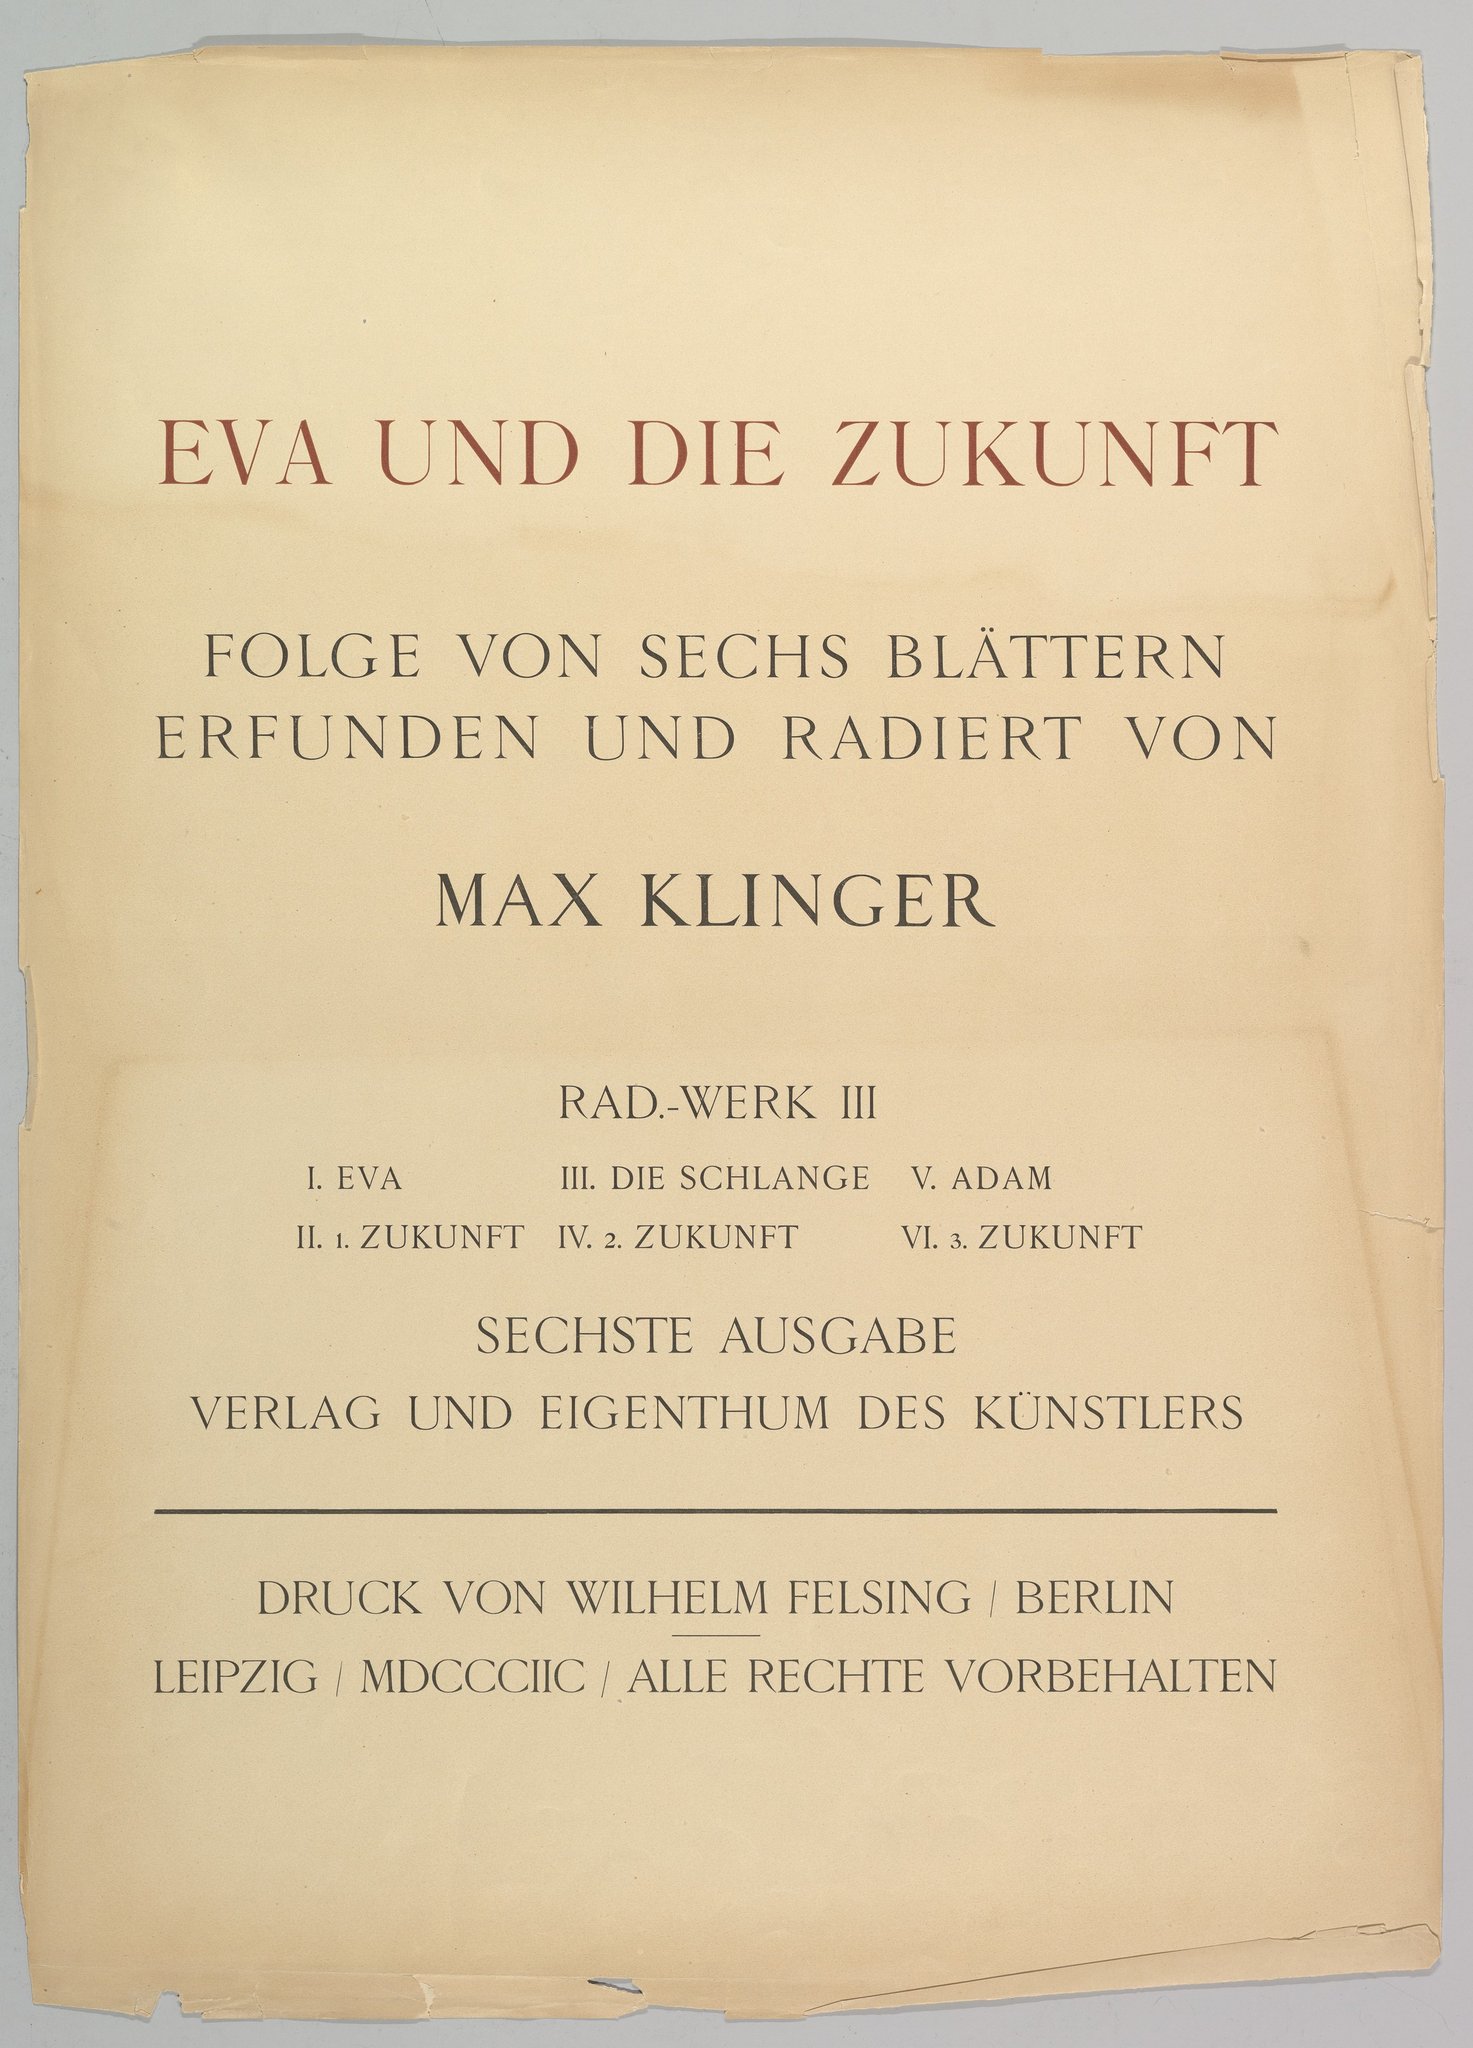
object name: print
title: Title Page from Eva und die Zukunft (Rad.-Werk III)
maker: max klinger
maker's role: artist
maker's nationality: german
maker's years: 1857-1920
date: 1898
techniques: etching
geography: germany